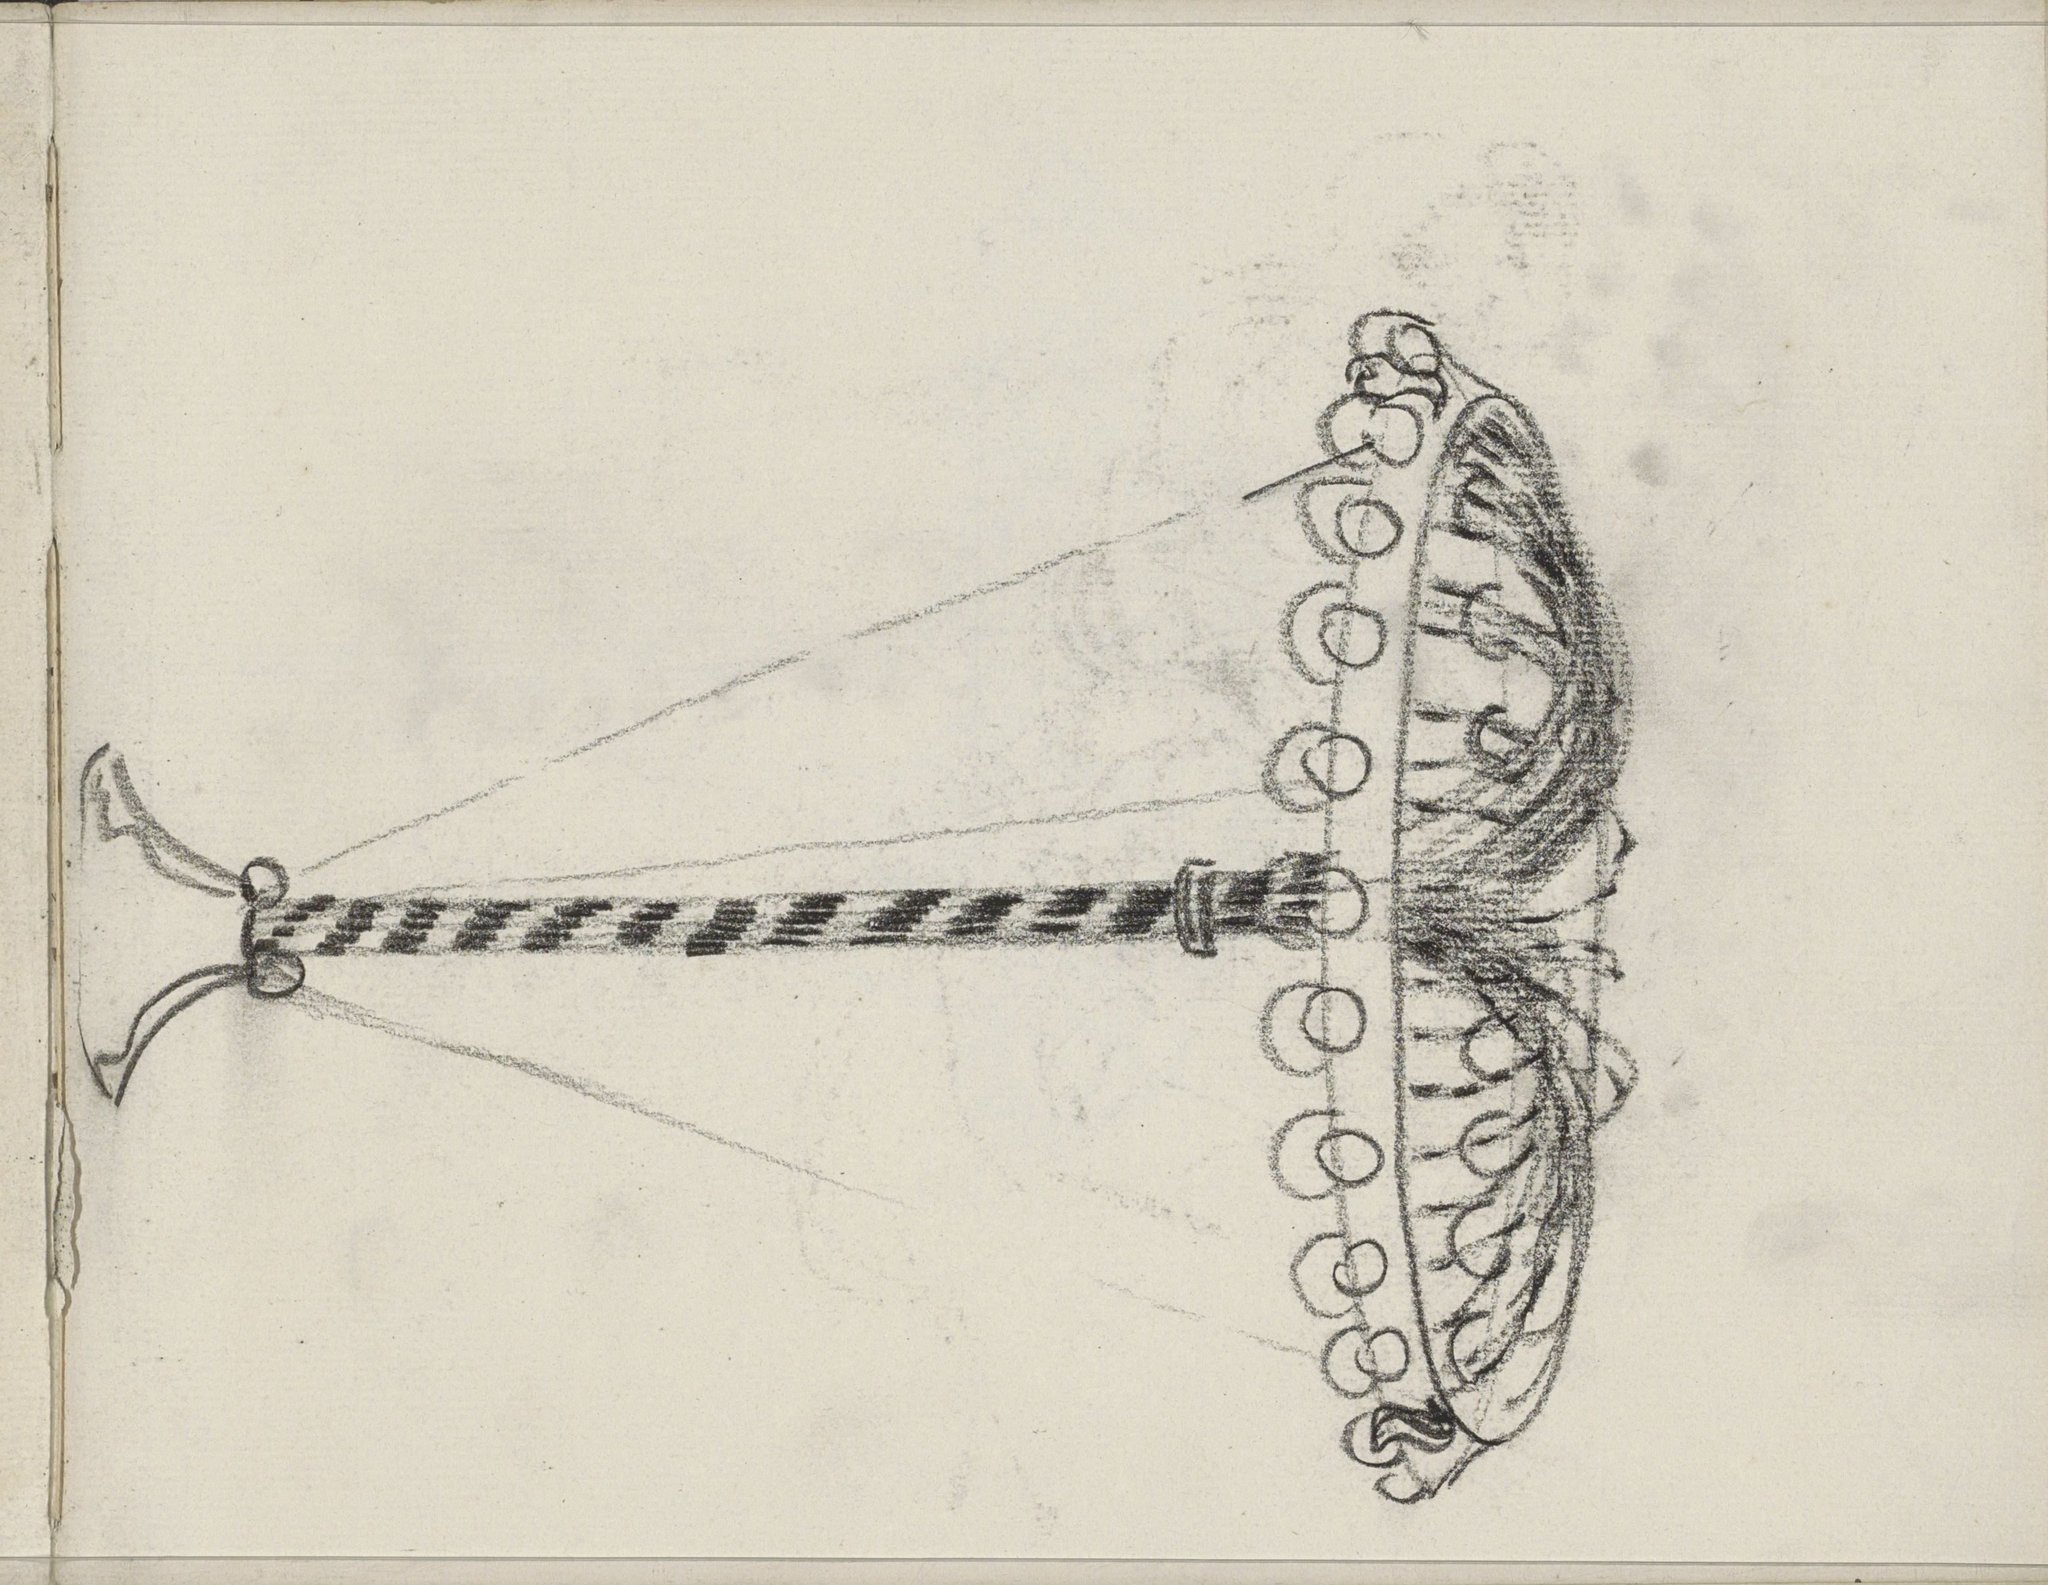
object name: sketchbook leaf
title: Ontwerp voor een kroonluchter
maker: carel adolph lion cachet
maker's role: draughtsman, print maker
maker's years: 1864-1945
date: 1896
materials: chalk, paper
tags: chandelier, candelabrum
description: Blad 30 recto uit een schetsboek met 44 bladen.